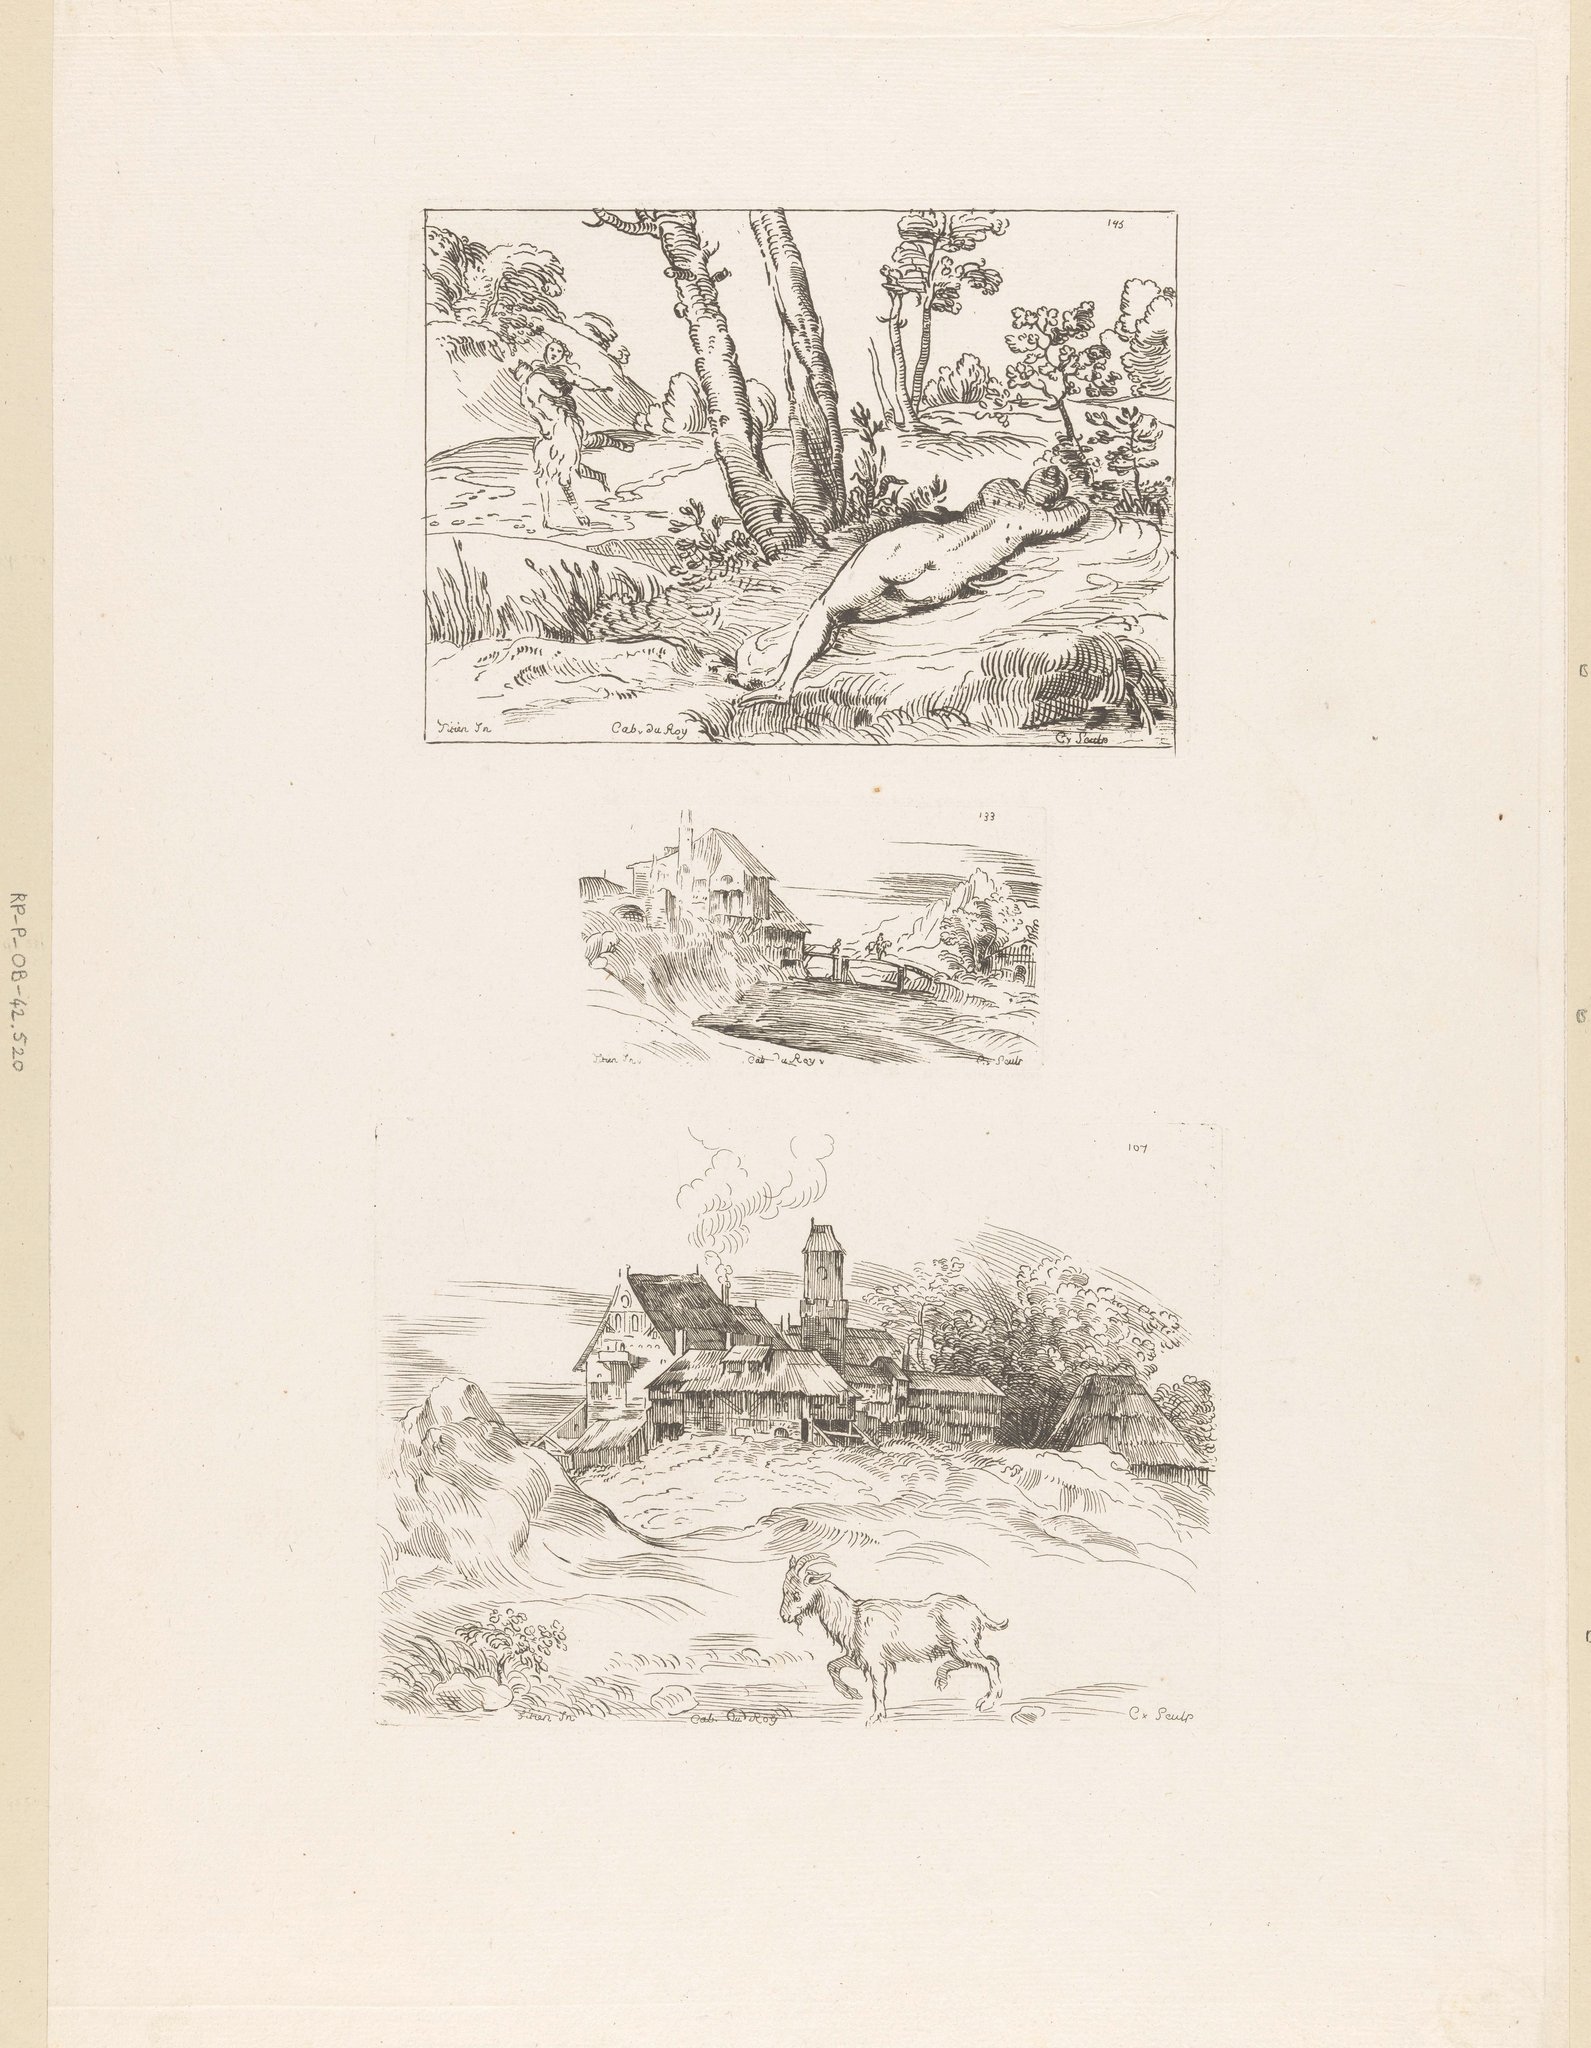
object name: print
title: Rivierlandschap met een brug waarop een ruiter en wandelaar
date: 1702-1765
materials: paper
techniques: etching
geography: france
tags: landscapes in the temperate zone - hh - ideal landscapes, nymphs (in general); 'ninfe in commune' (ripa), sleeping; unconsciousness, bridge, goat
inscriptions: collector's mark: Lugt 240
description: Maakt deel uit van een serie getiteld: "Cabinet du Roy" van 222 etsen naar tekeningen uit de Franse koninklijke collectie.